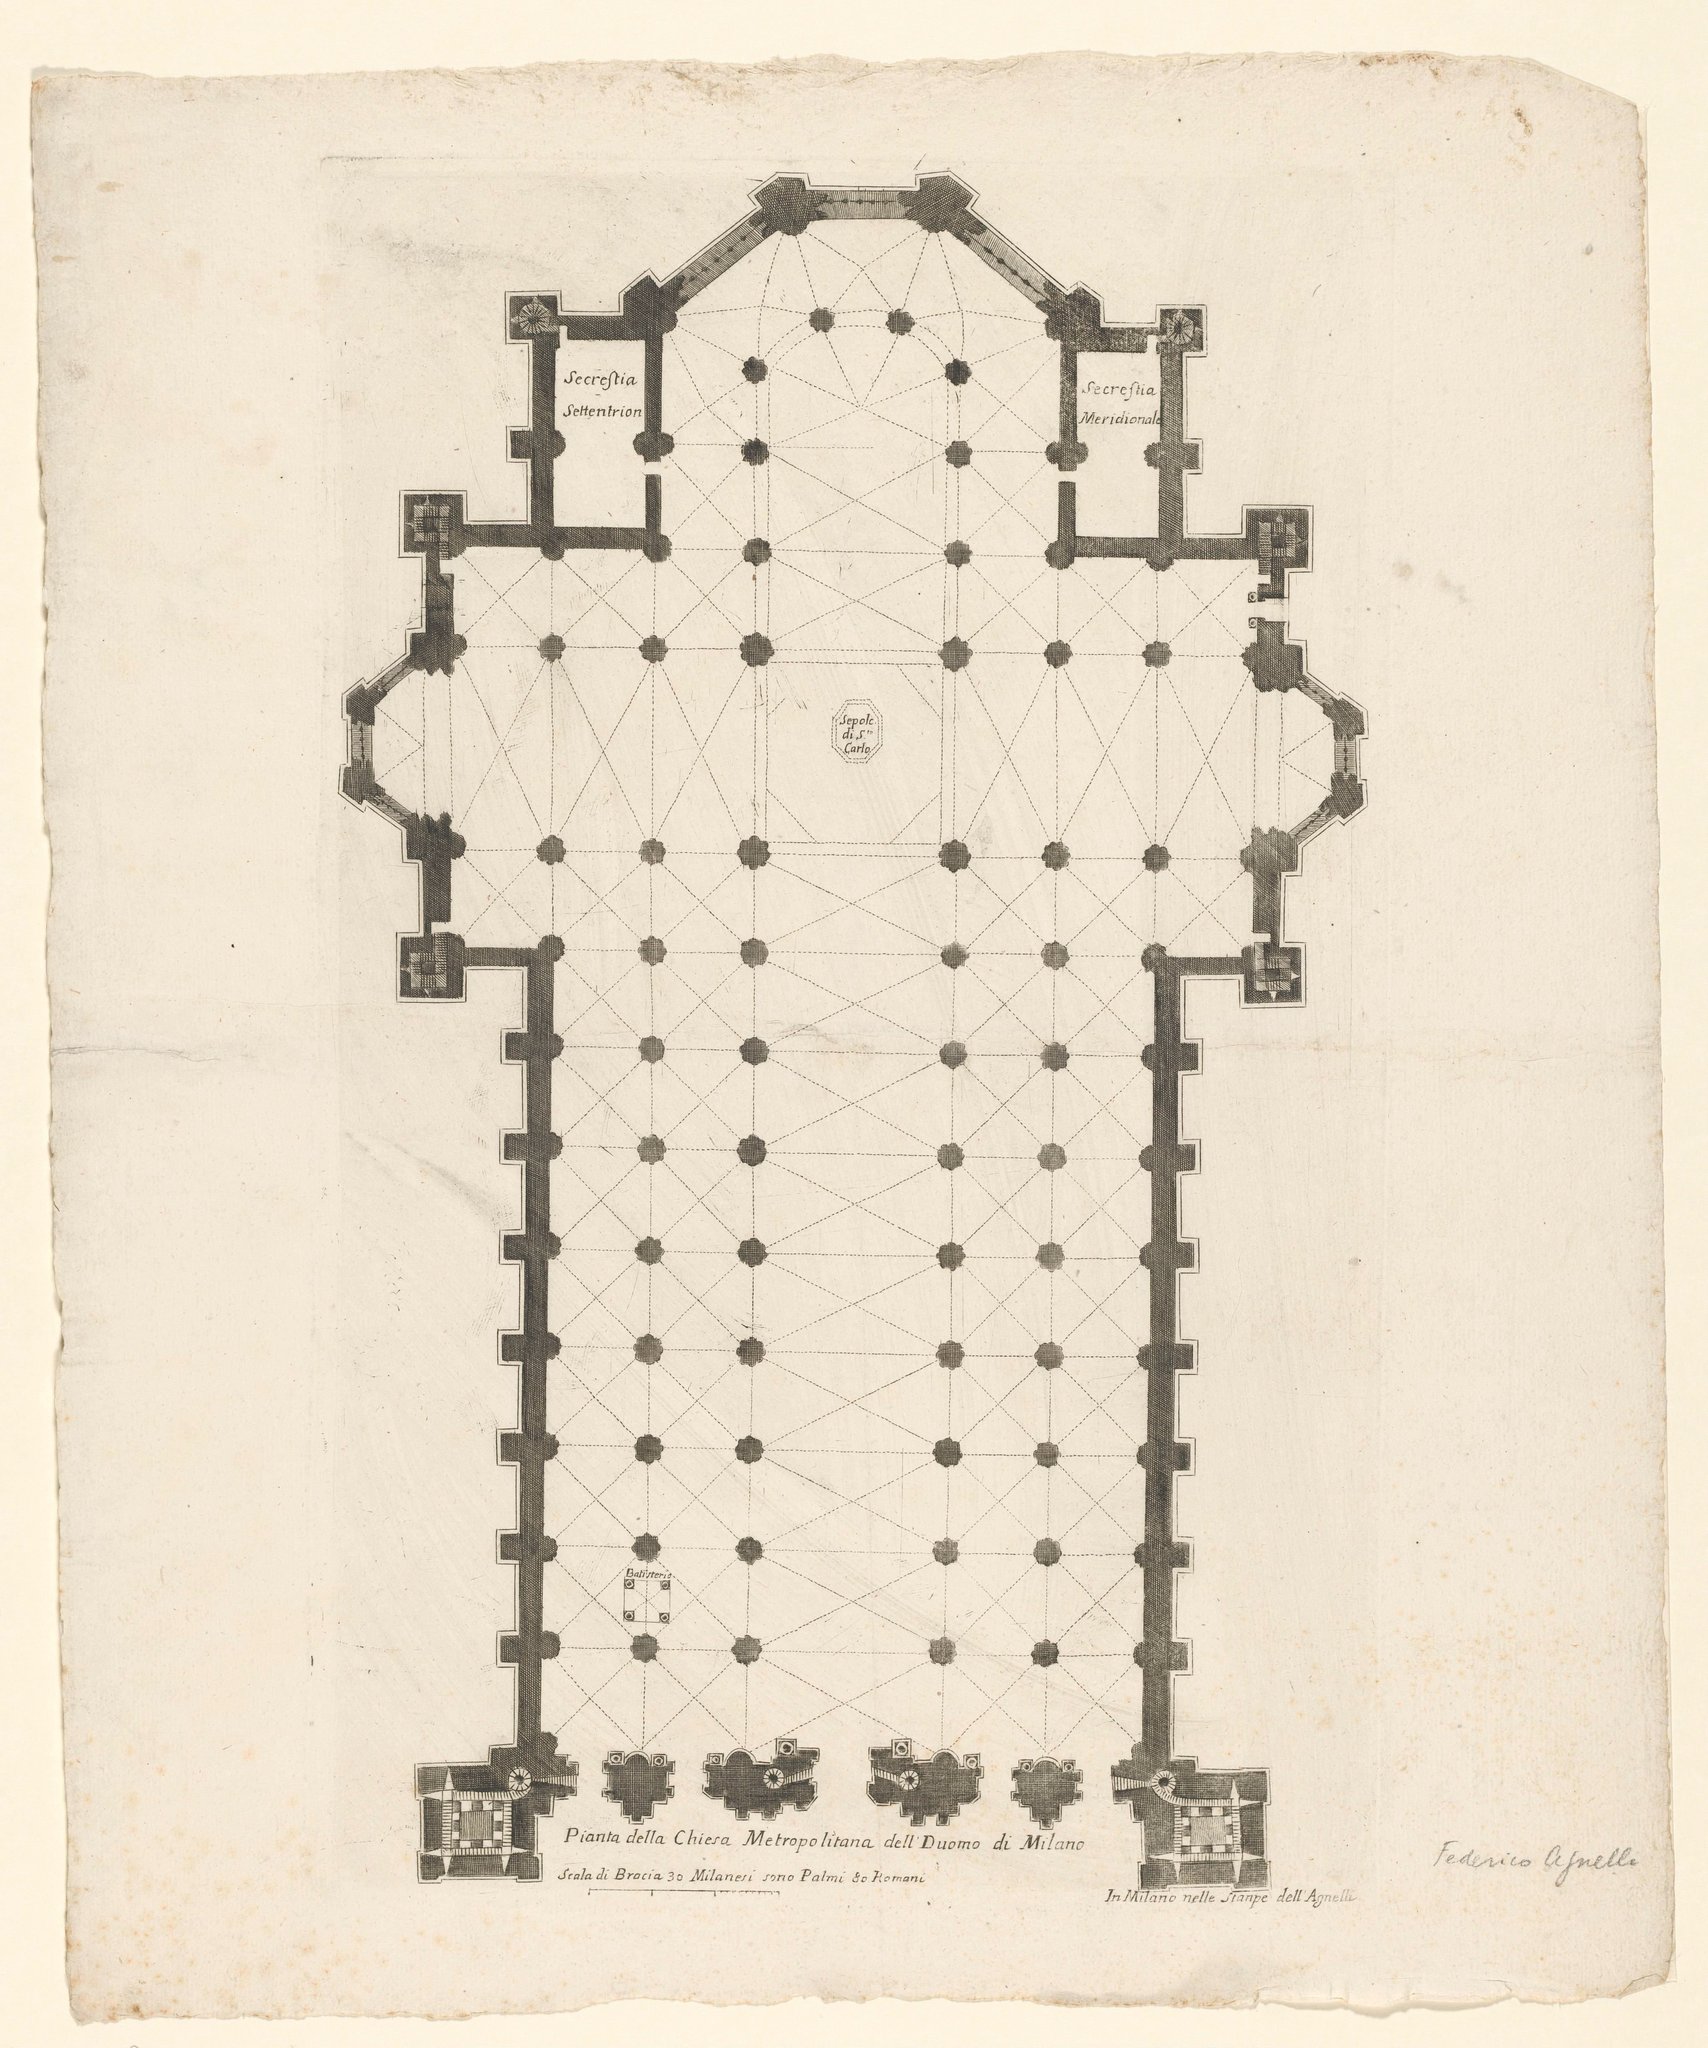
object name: print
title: Plattegrond van de Dom van Milaan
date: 1636-1702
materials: paper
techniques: engraving, etching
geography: milan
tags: interior of church, plan ~ architecture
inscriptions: collector's mark: Lugt 2228